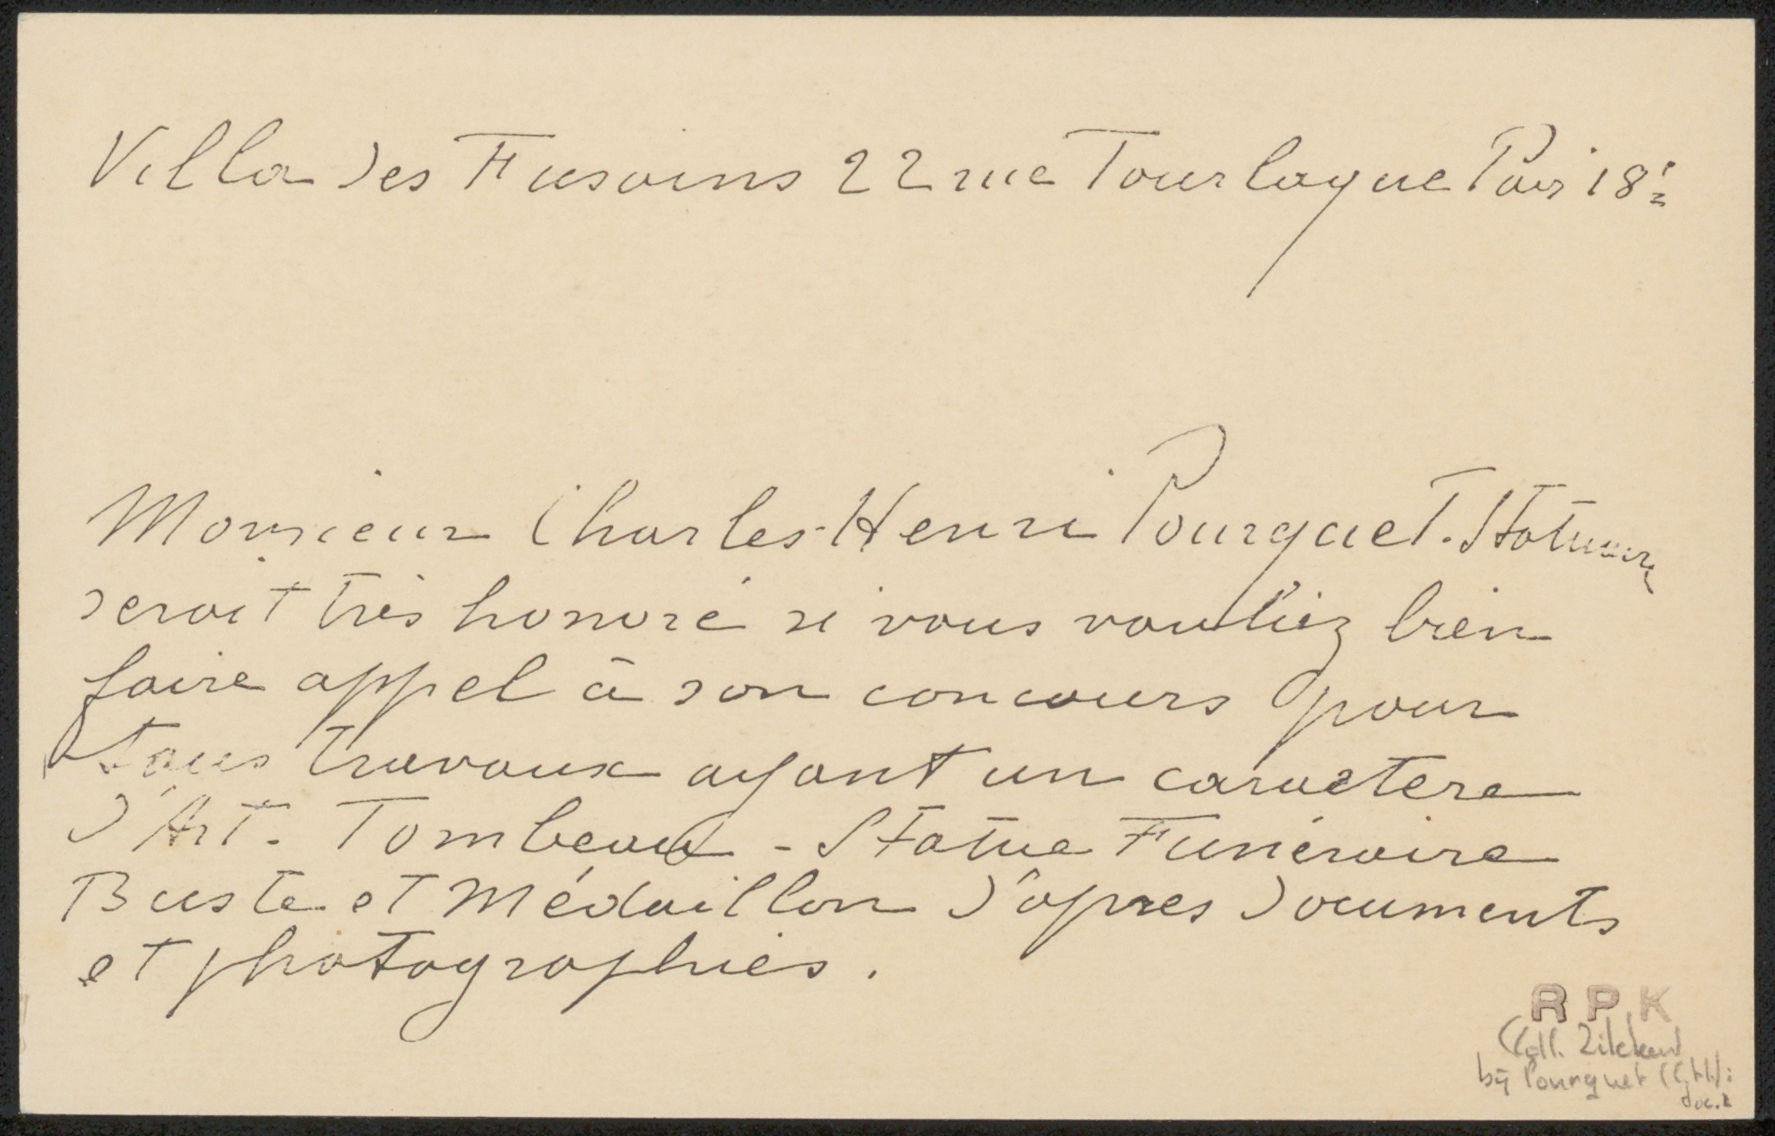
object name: ansichtkaart, prentbriefkaart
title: Prentbriefkaart aan de familie van Philip Zilcken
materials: cardboard, ink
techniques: pen, writing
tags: the hague, painter, draughtsman, philip zilcken, sculpture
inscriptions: collector's mark: ‘RPK’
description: RP-D-1982-43-POURQUET(C.H.)-DOC.2 en RP-D-1982-43-POURQUET(C.H.)-DOC.3 zijn vermoedelijk samen verstuurd met RP-D-1982-43-POURQUET(C.H.)-DOC.1.